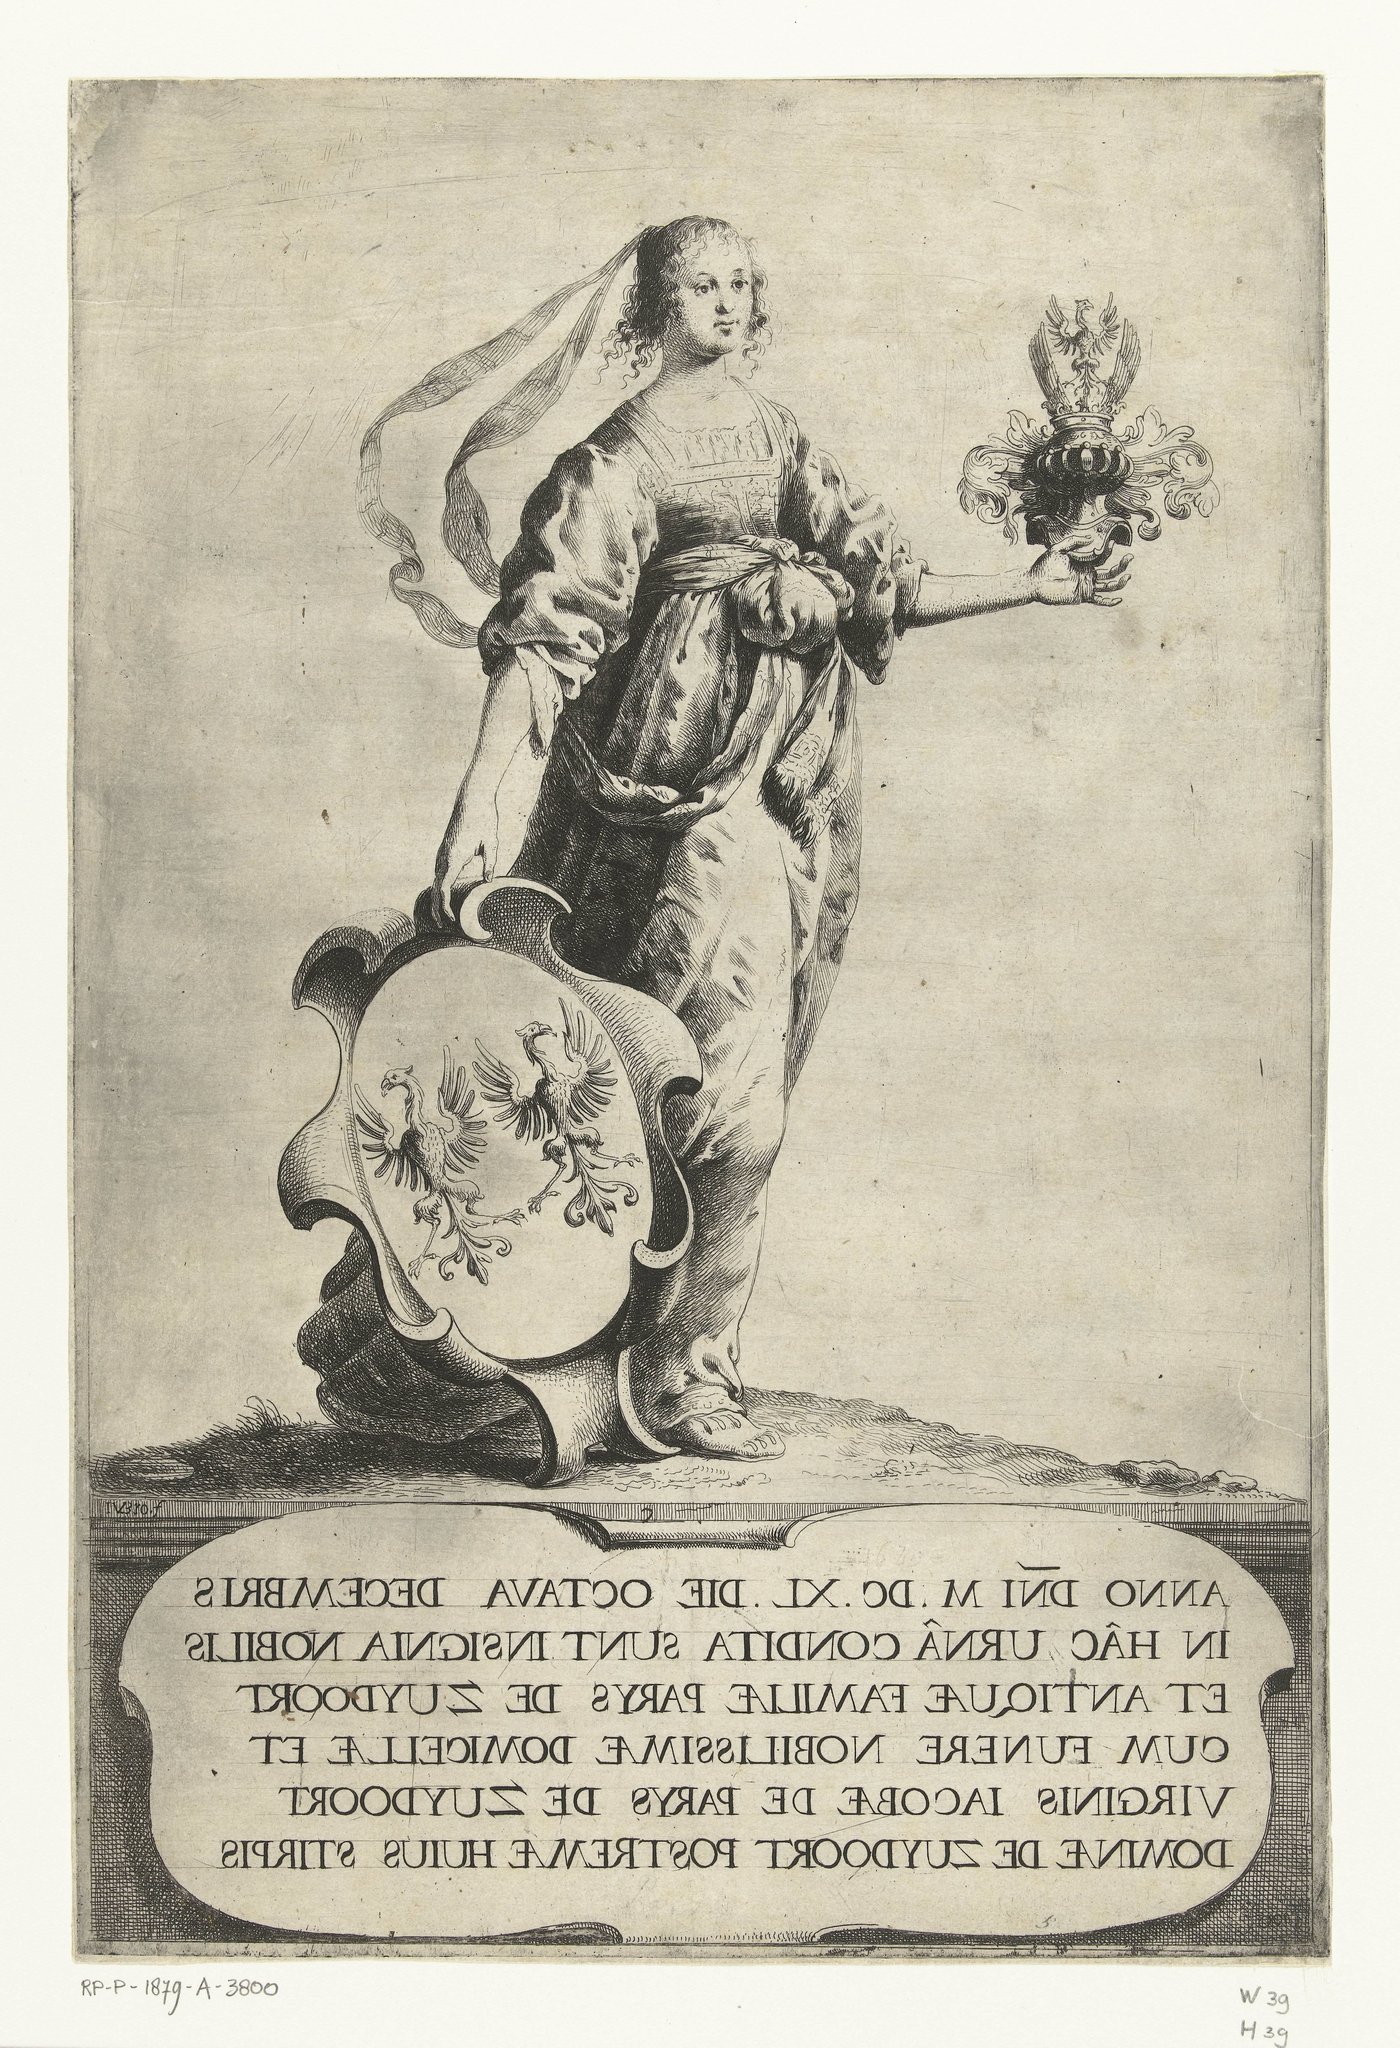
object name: print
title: Vrouw staand met wapenschild met wapen van geslacht Van Parijs van Zuidoort en versierde helm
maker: jan gerritsz. van bronckhorst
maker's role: draughtsman, painter, print maker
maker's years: 1603-1661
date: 1640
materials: paper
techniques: engraving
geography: netherlands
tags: jacoba van parijs van zuydoort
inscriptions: collector's mark: Lugt 2228, inscription: ‘Anno dni MDCXL die octava Decembris in hac urna condita sunt insignia nobilis et antiquae familiae Parijs de Zuydoort cum funere nobilissimae domicellae et virginis Iacobae de Parys de Zuidoort Dominae de Zuydoort postremae huius stirpis’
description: Vrouw staand met wapenschild met wapen van geslacht Van Parijs van Zuidoort en versierde helm. Op een cartouche staan zes regels tekst in Latijn in spiegelschrift waarin onder andere deze familienaam genoemd wordt.